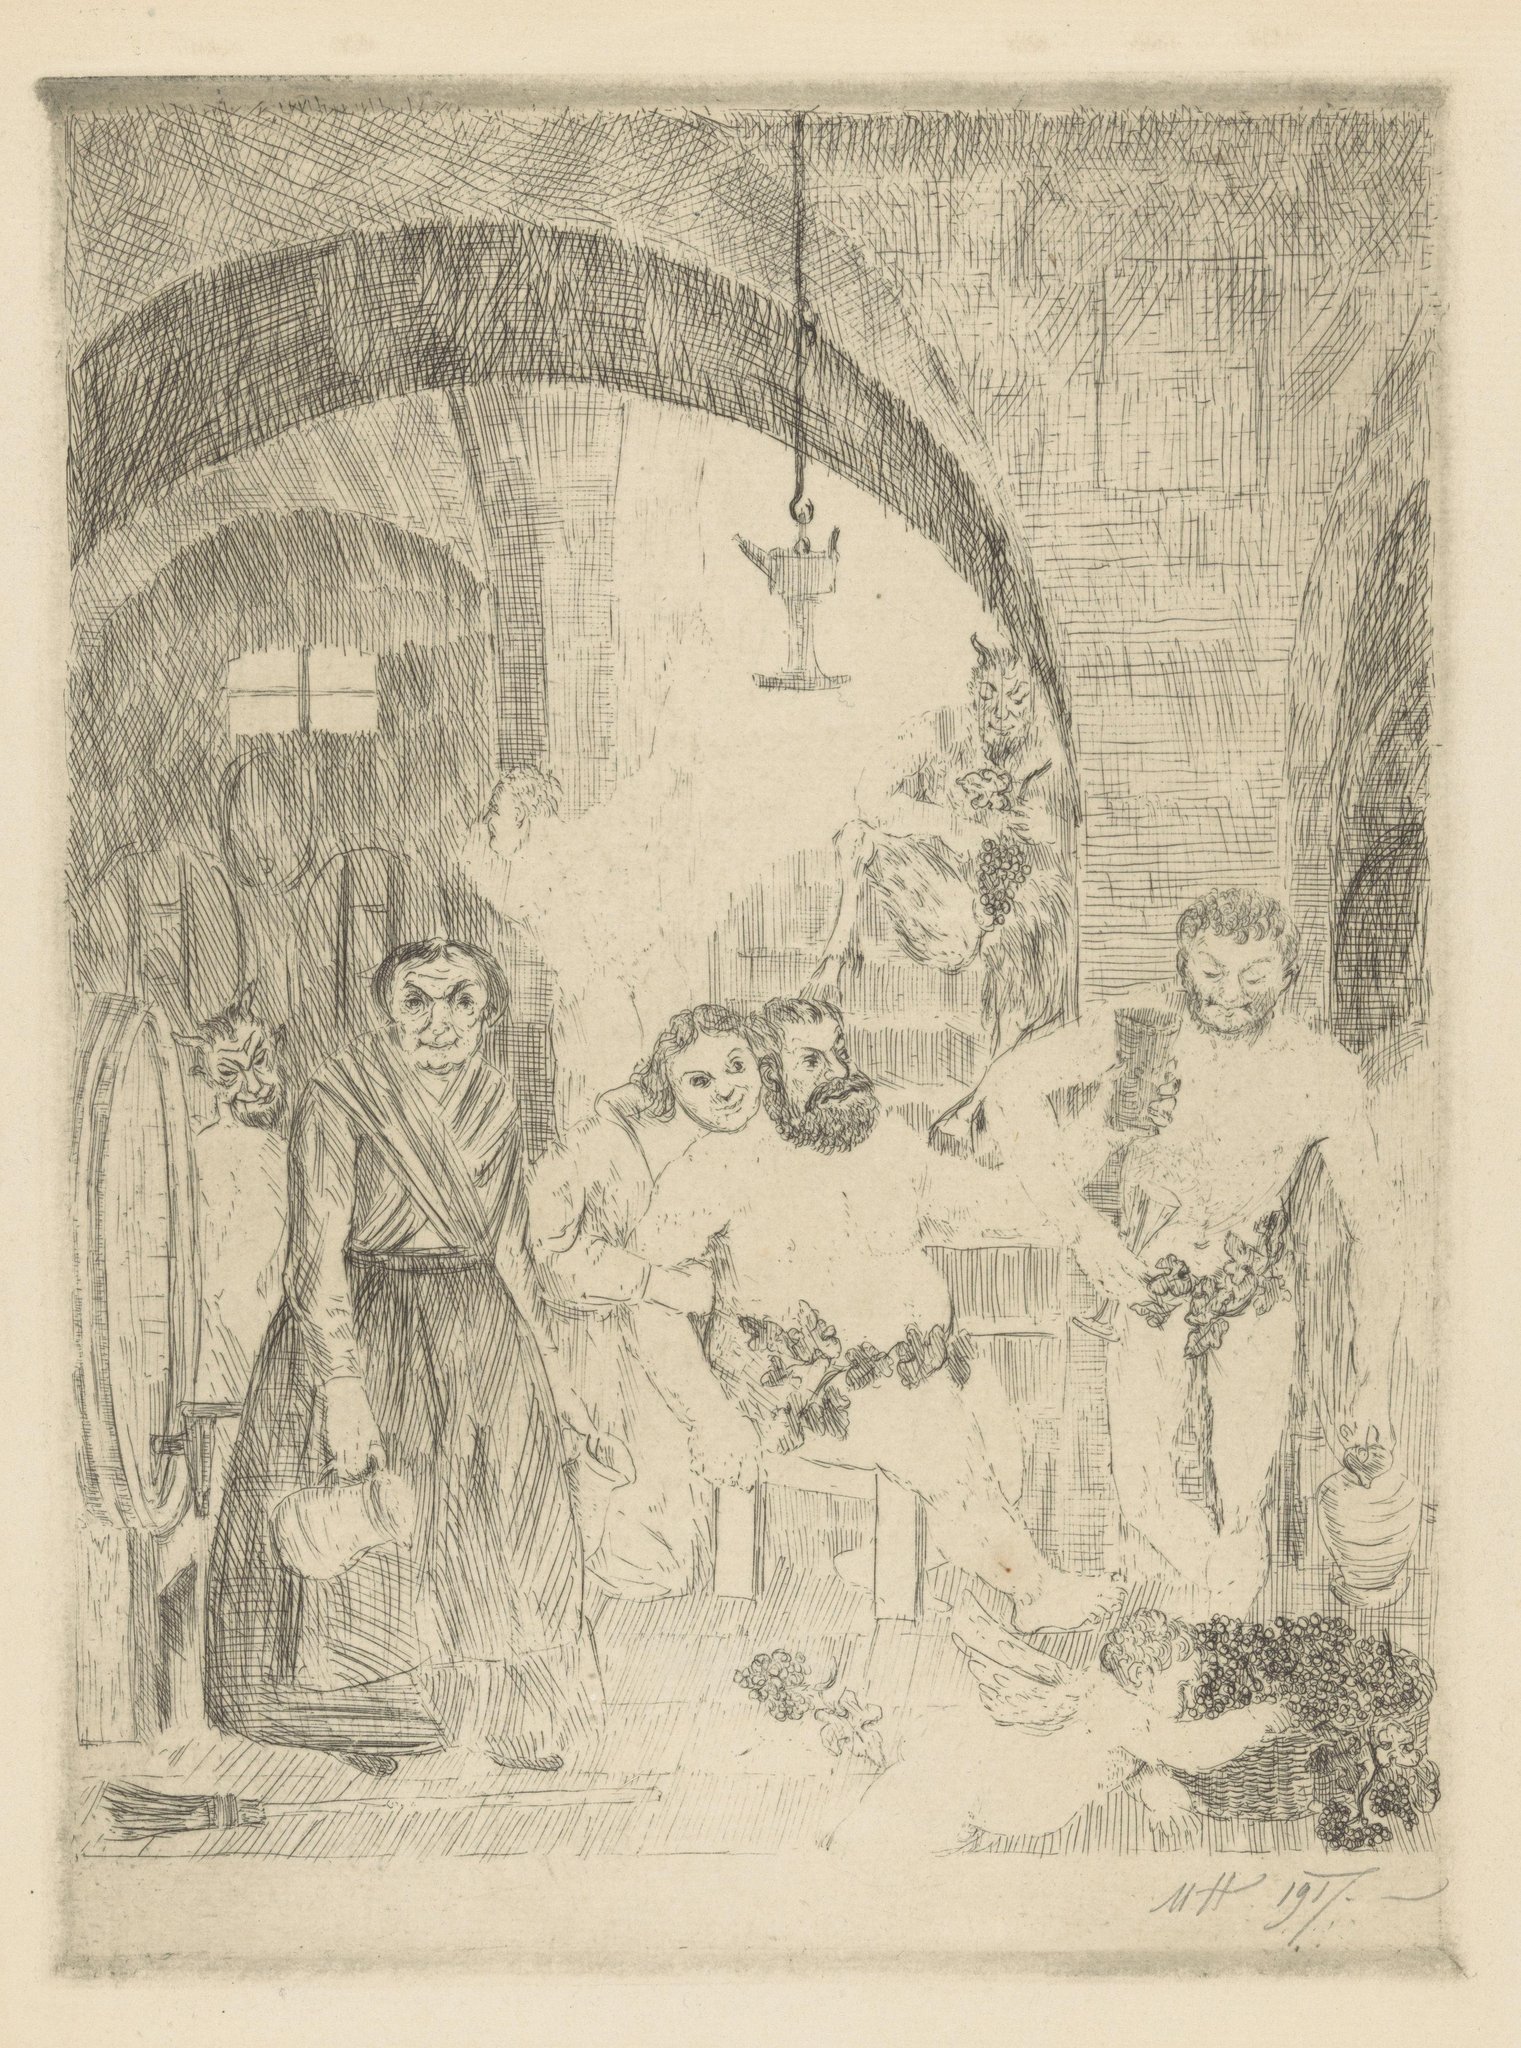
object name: print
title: Bacchus en Silenus in een wijnkelder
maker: marius holleman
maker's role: draughtsman, print maker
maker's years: 1878-1926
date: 1916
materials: paper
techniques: etching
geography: groningen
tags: wine-cellar, (story of) bacchus (dionysus), liber, (story of) silenus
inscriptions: collector's mark: Lugt 2228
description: Links bij een vat staat een oude vrouw met twee kruiken. Aan het plafond boven Bacchus hangt een aambeeld.